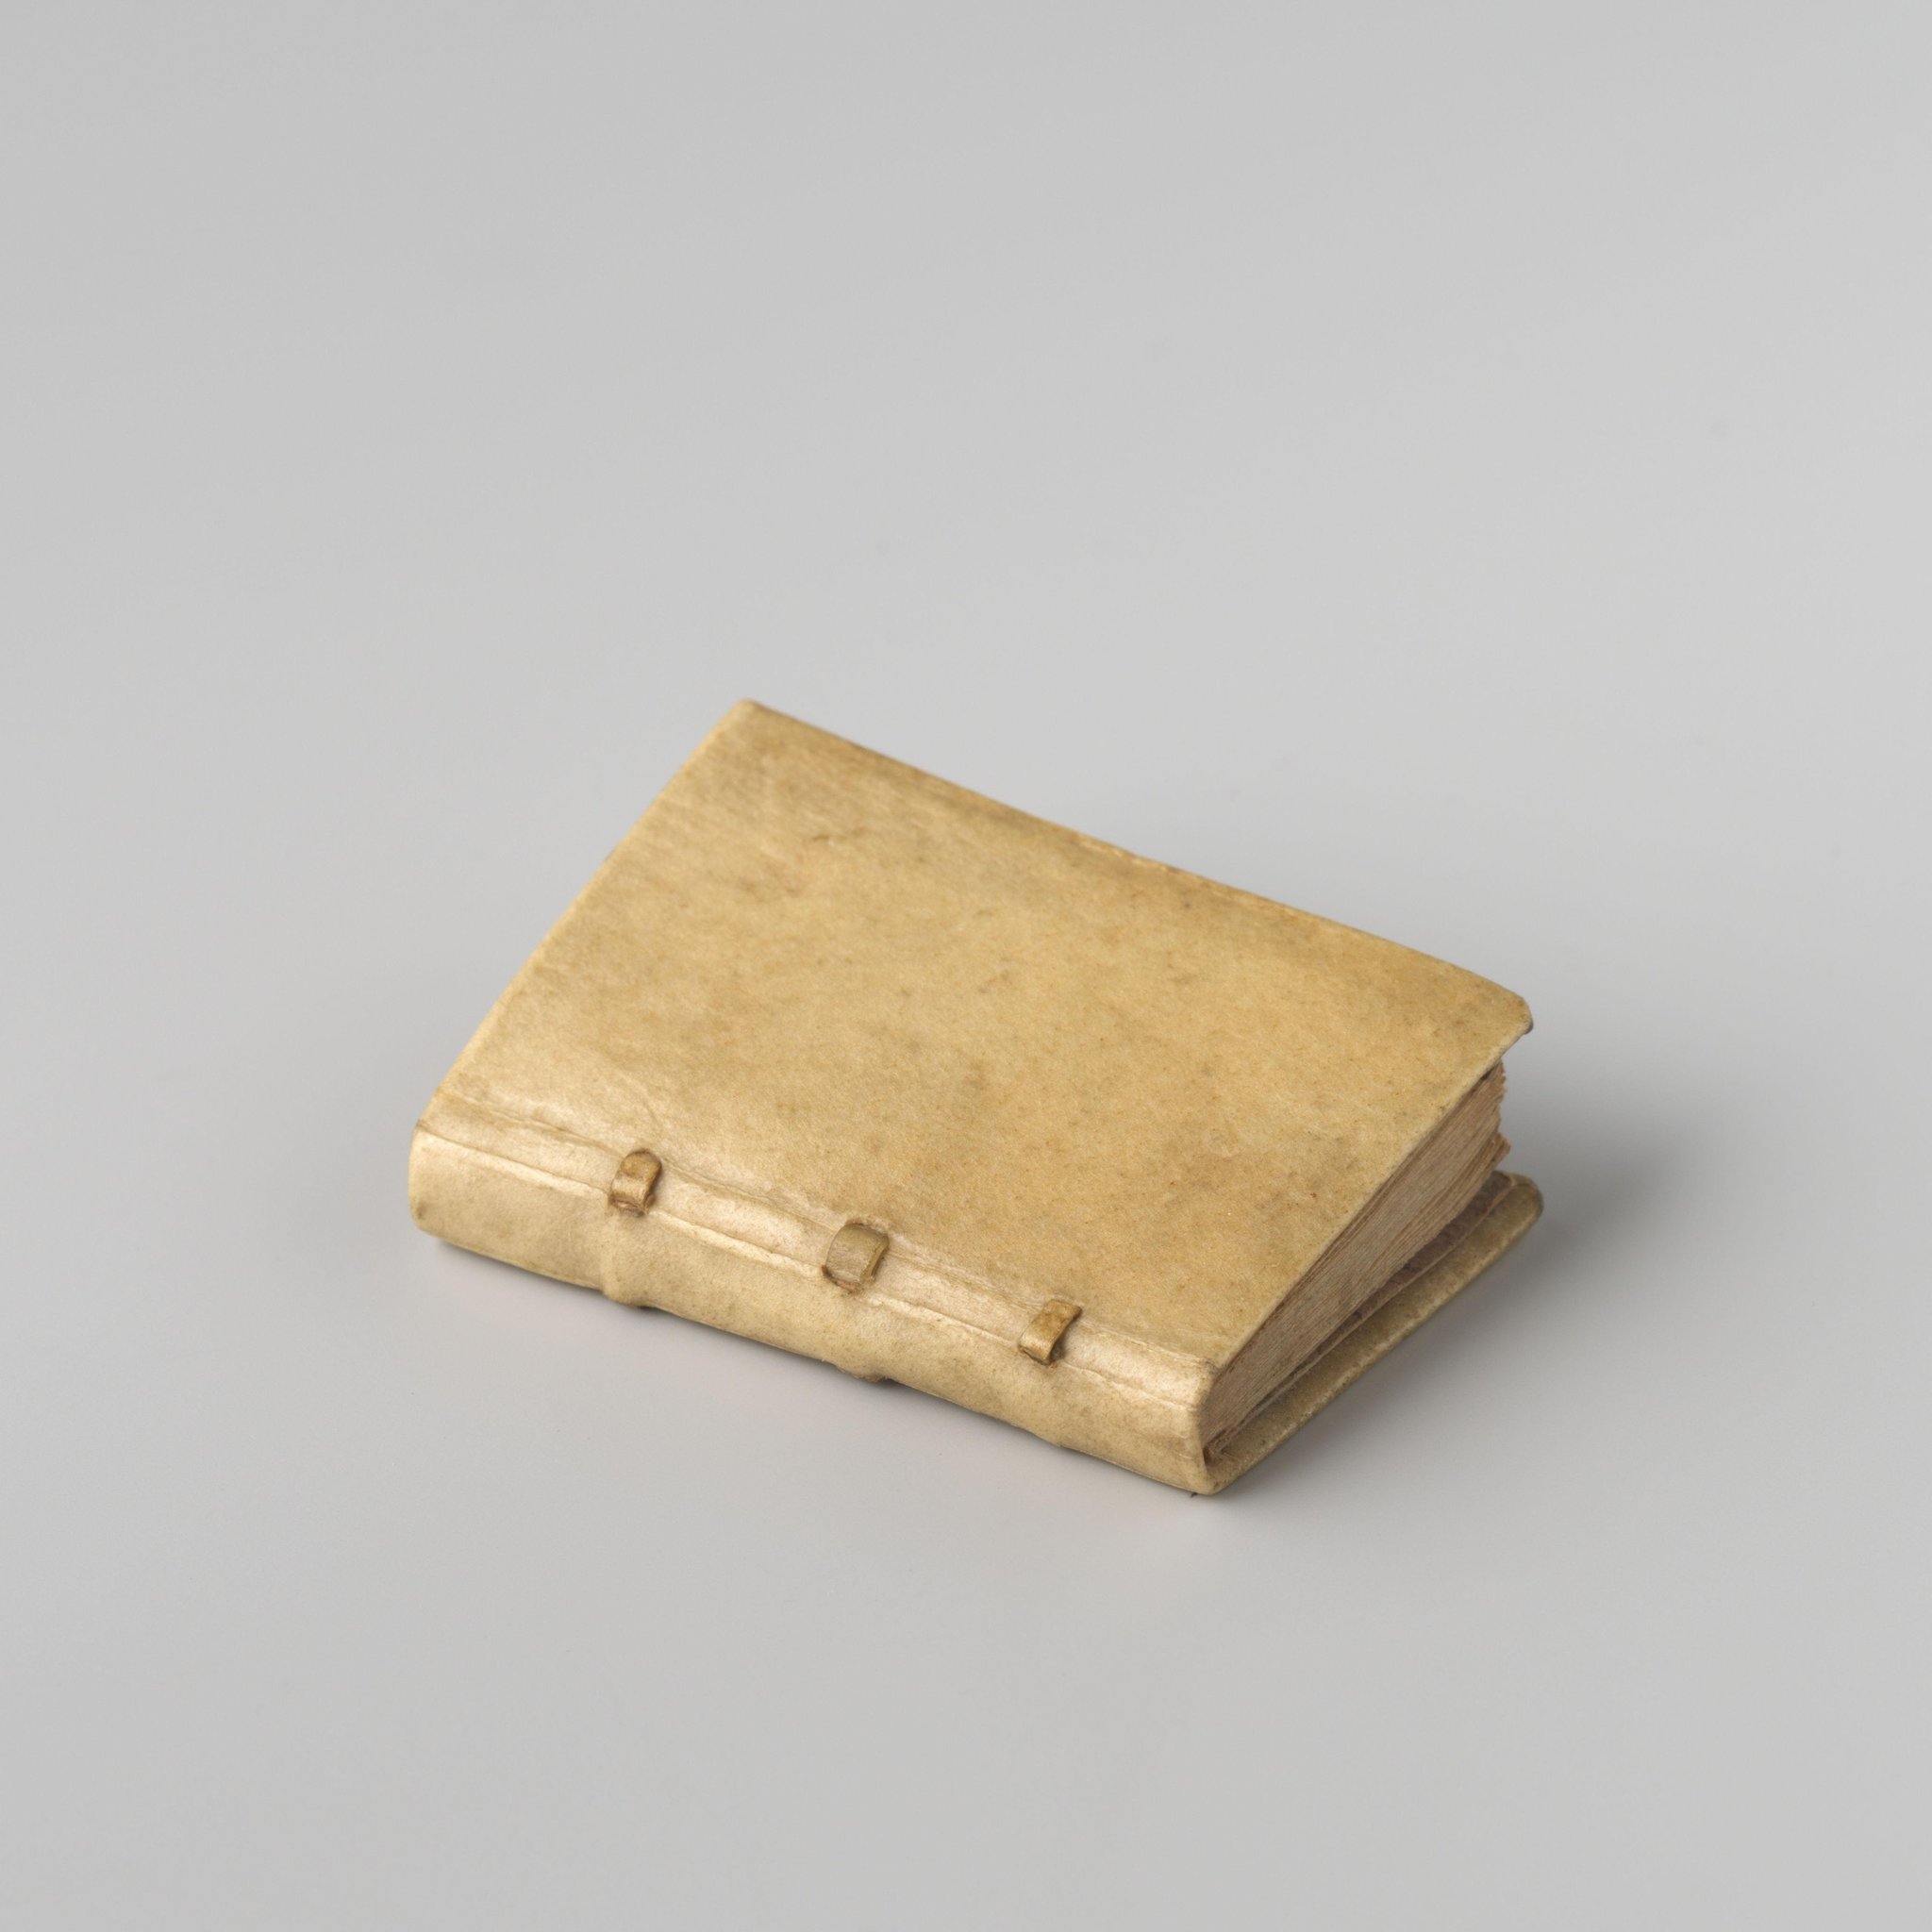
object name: miniature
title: Boek over de zijdeteelt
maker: Anonymous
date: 1690-1710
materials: paper, parchment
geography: amsterdam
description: Boek, gebonden in blank perkament (splitsel-binding), schutbladen van gemarmerd papier, snede onversierd; acht katernen van vier bladen, 1ste blanco, vijftig bladzijden met bruine inkt beschreven. De tekst behandelt de teelt van zijdenrupsen en het profijt daarvan.